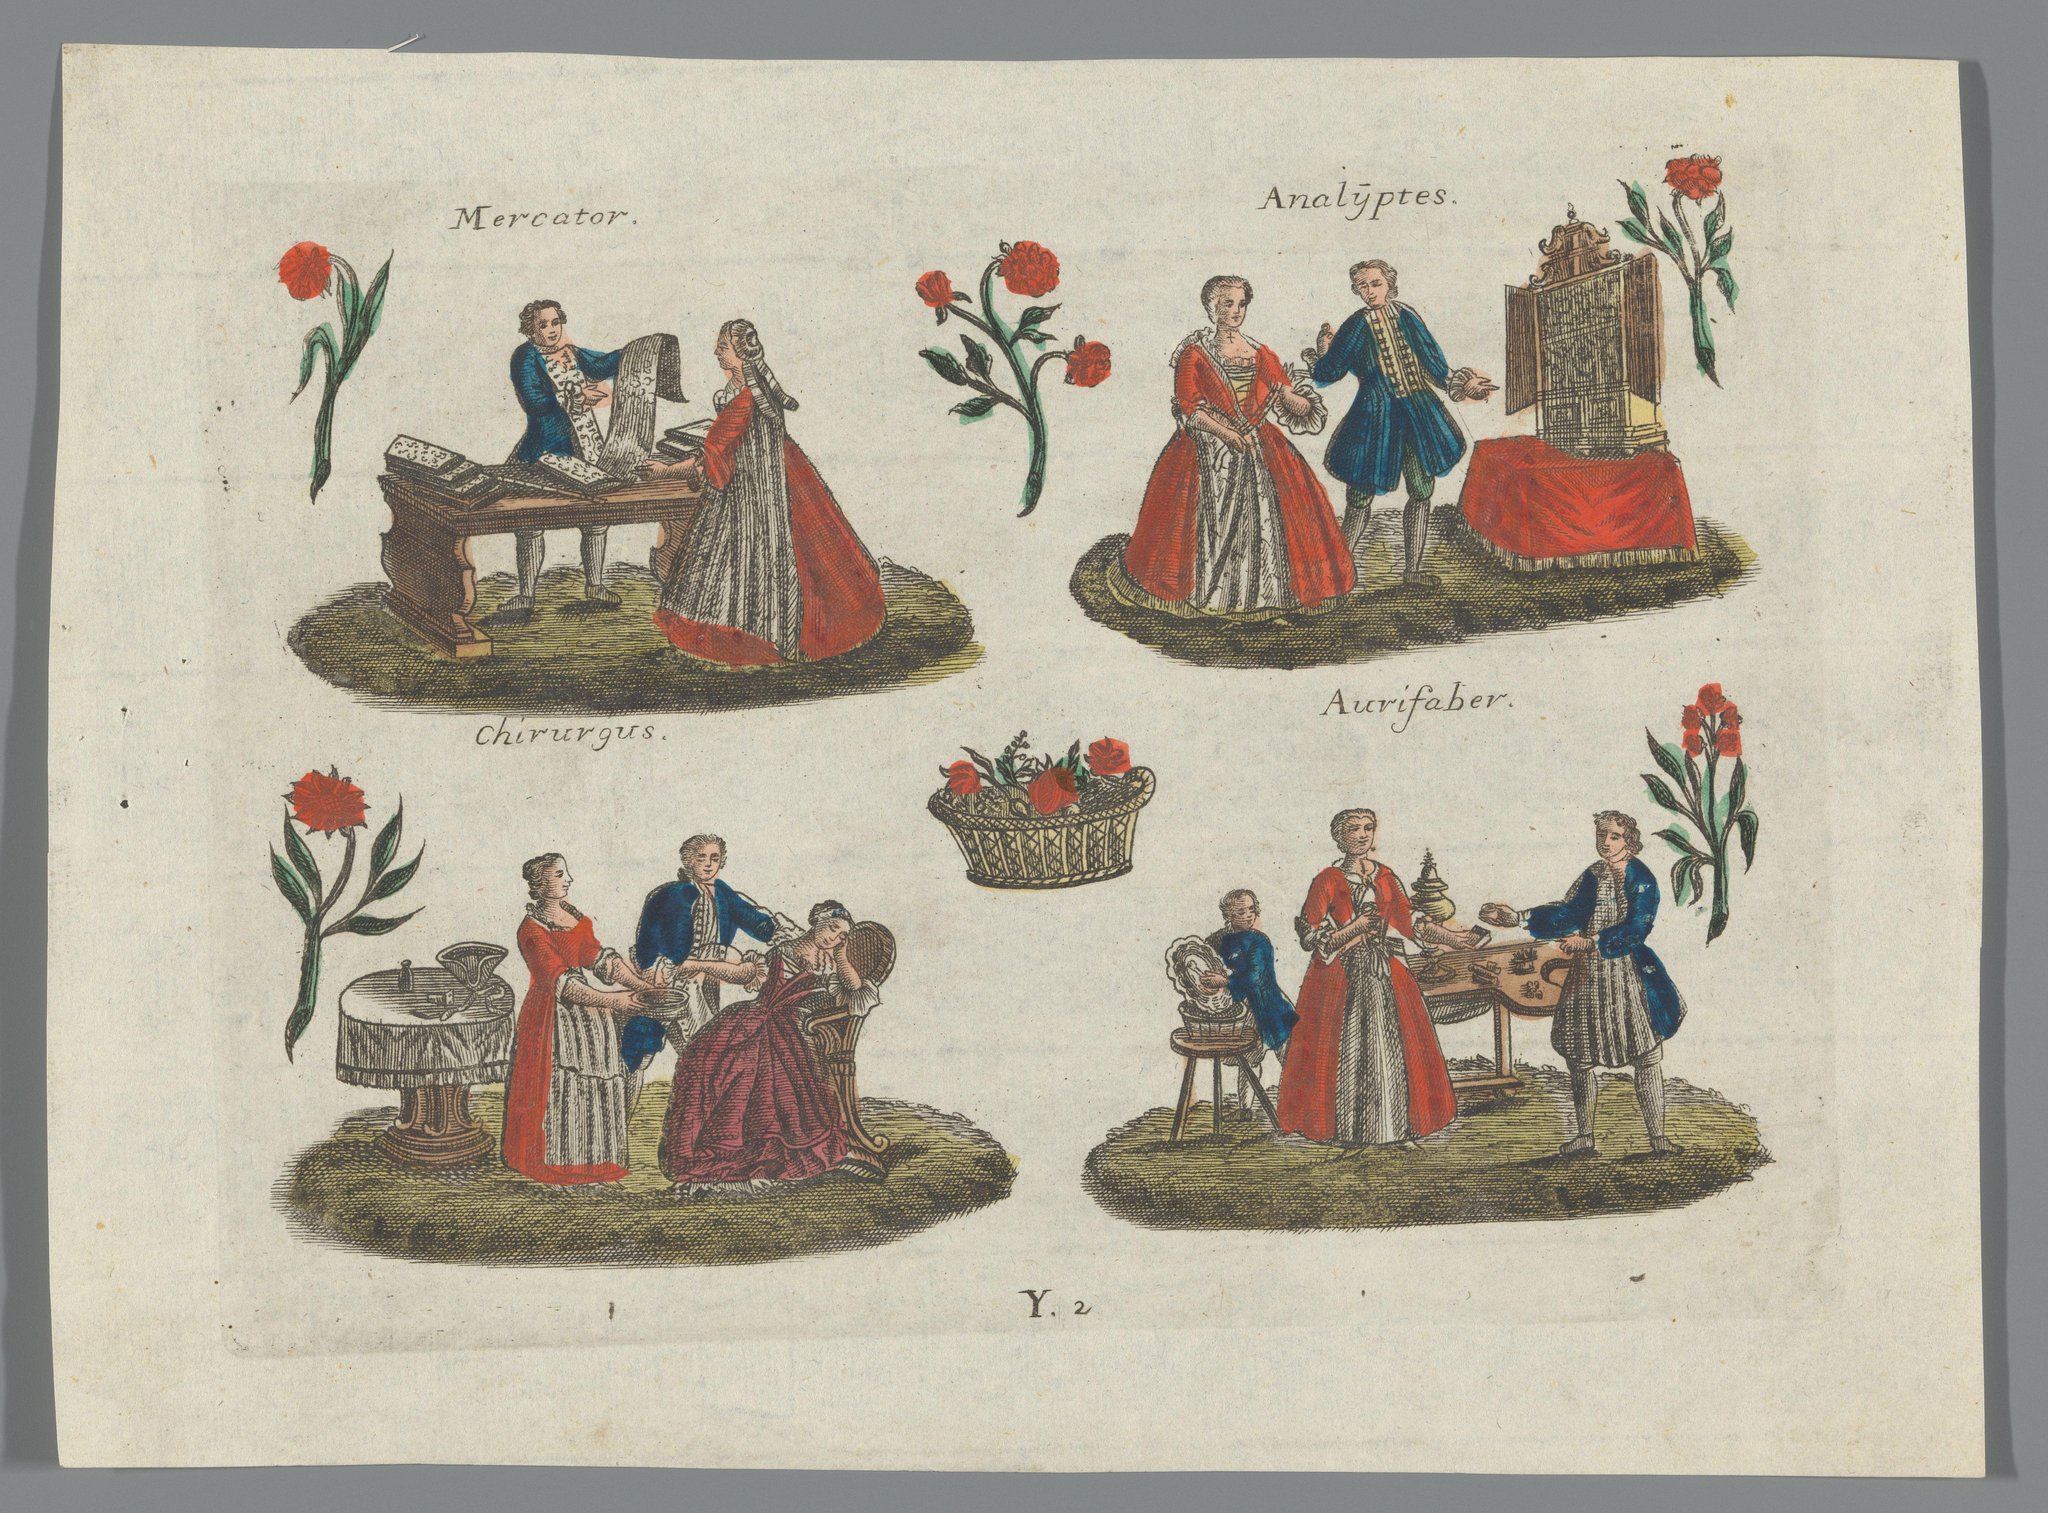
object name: print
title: Bladen met knipplaatjes en decoratieve randen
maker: Anonymous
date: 1750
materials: paper, watercolor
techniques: etching, hand coloring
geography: paris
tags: presenting a work of art to the public; performing, interpreting, reciting, physician, doctor, jeweller, goldsmith, silversmith, wandering or travelling merchant, peep-show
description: Vier scènes van vrouwen bij mannen in verschillende beroepen: een textielverkoper, een man met een kijkkast, een arts en een goudsmid. Midden onder genummerd: Y. 2. Een van 39 bladen met knipplaatjes en decoratieve randen.